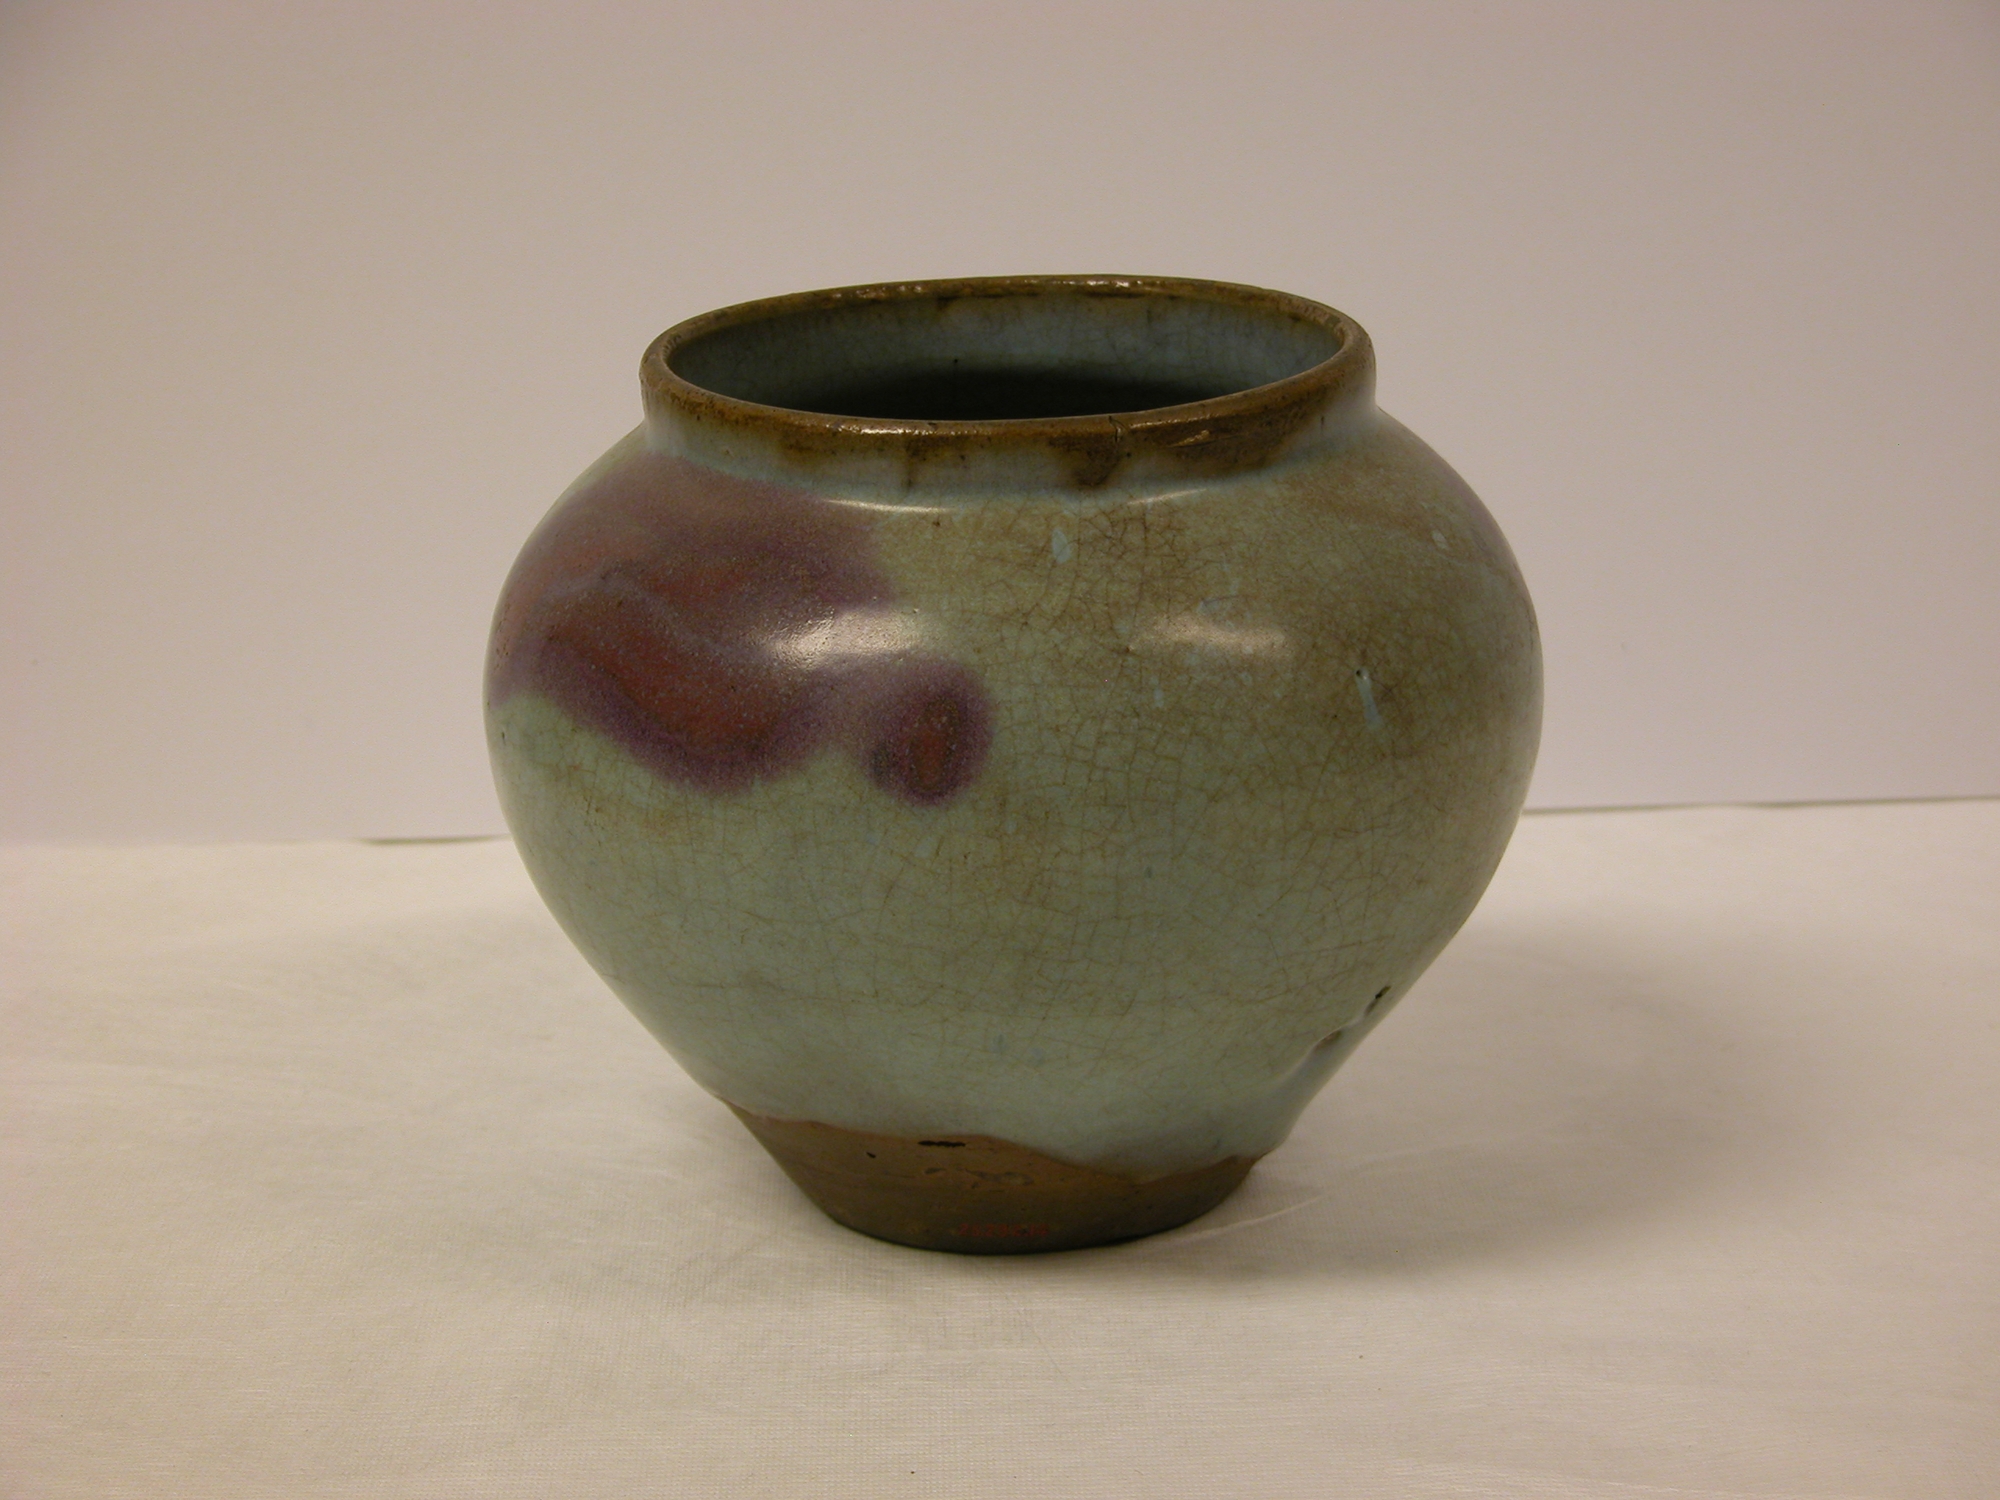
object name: jar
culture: chinese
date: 1368-1644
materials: glaze, stoneware